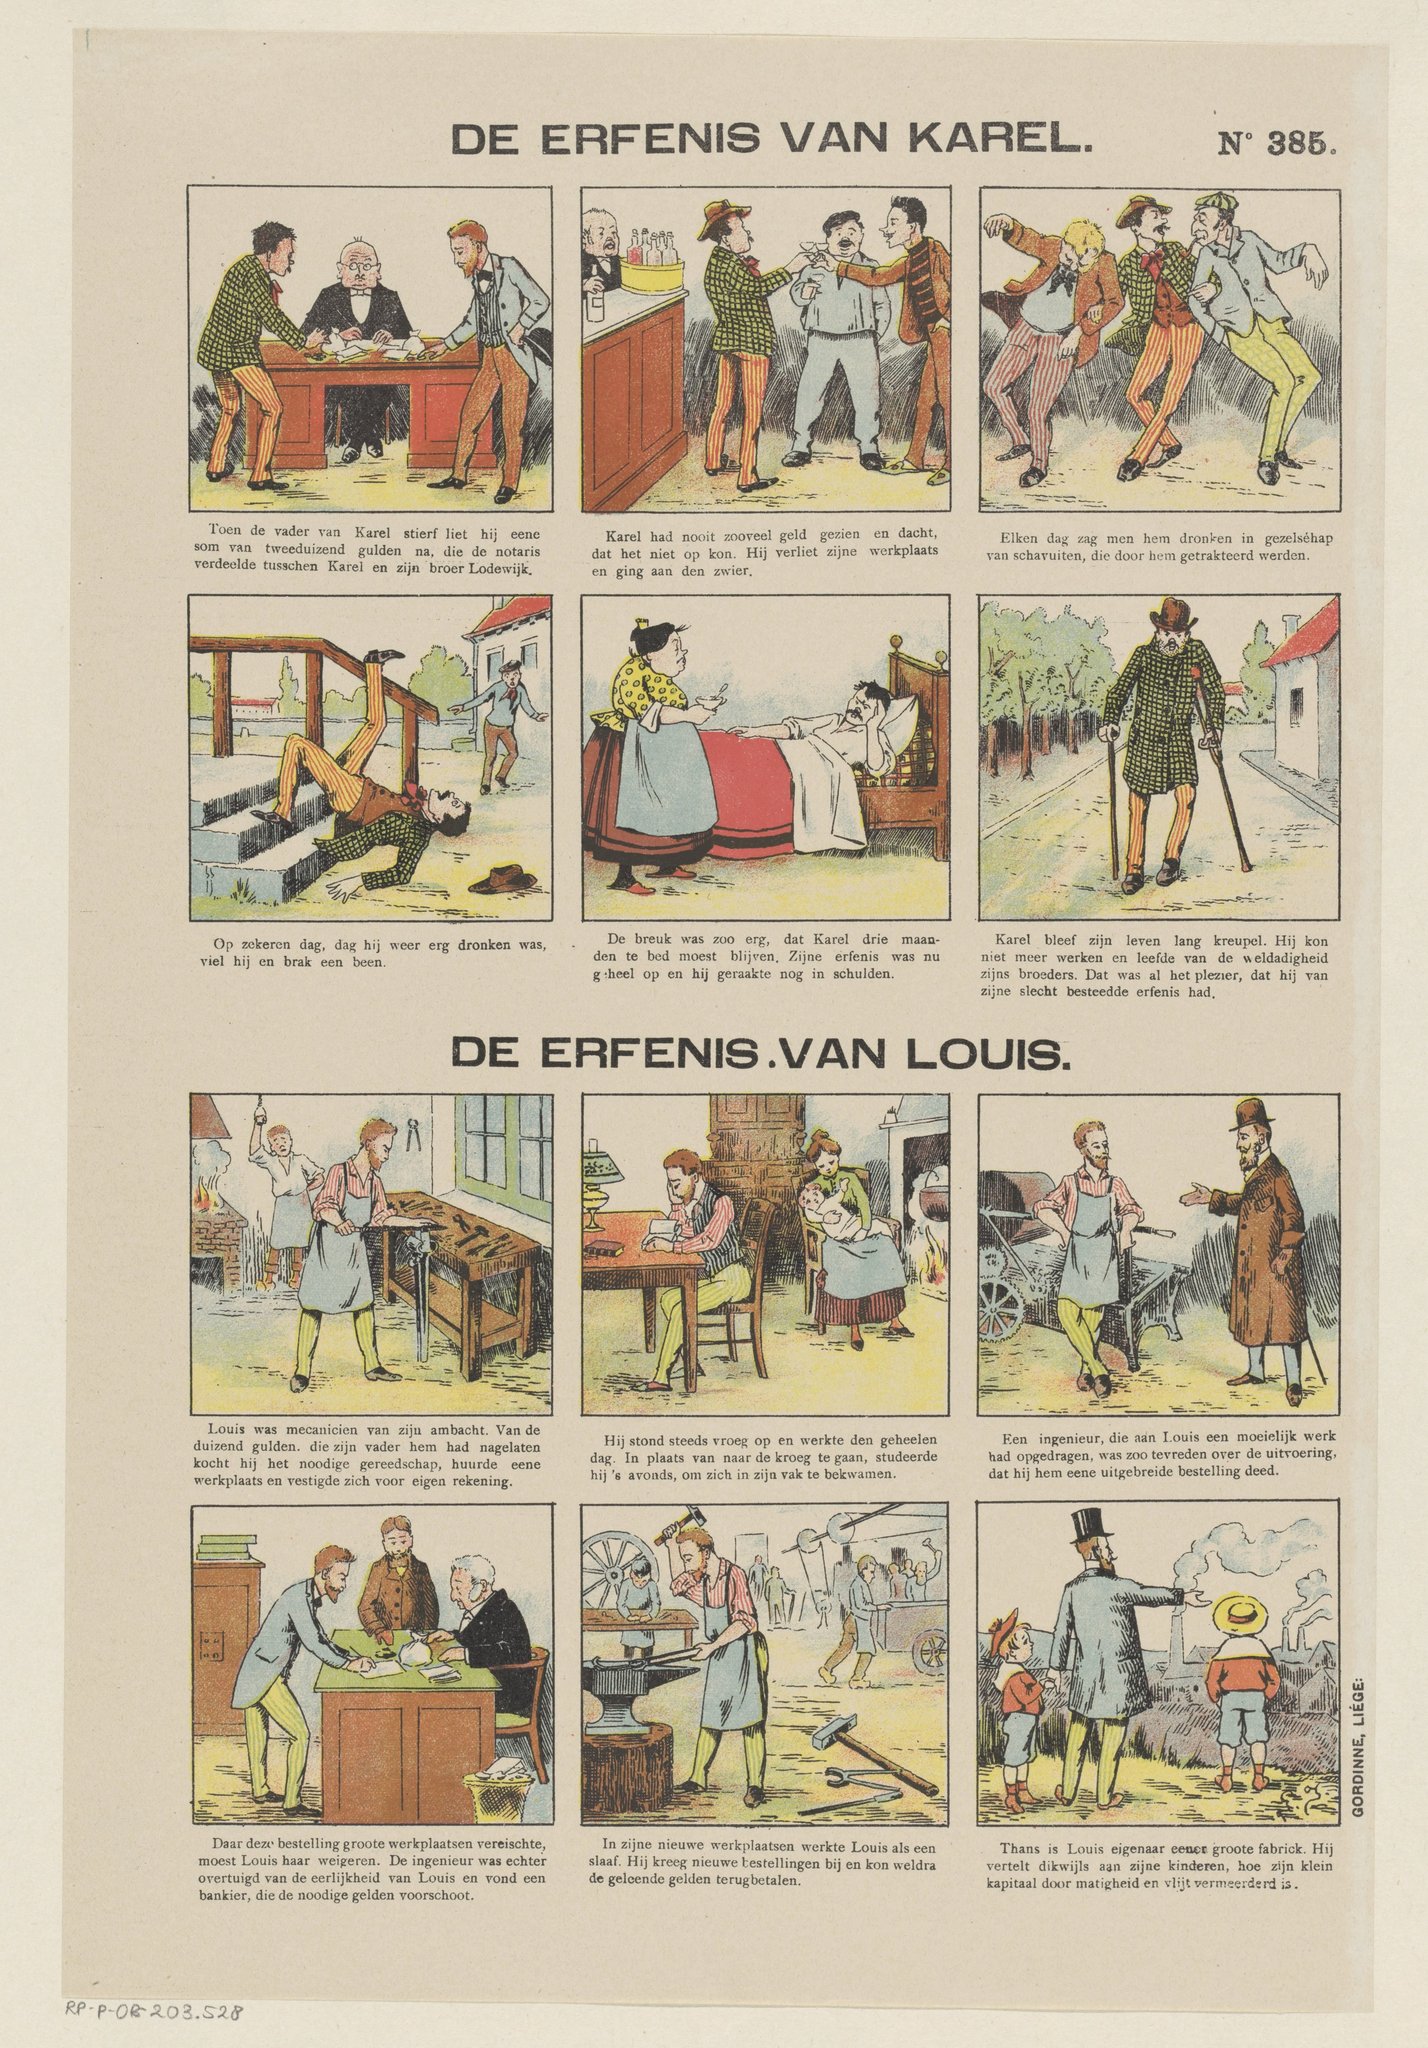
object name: popular print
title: De erfenis van Karel / De erfenis van Louis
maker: Anonymous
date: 1894-1959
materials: paper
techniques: lithograph, letterpress printing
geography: liège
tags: craft-production, skilled handiwork, sobriety; 'sobrietà', 'astinenza' (ripa), drunkard, bad behaviour, good behaviour, drunkenness, crafts and industries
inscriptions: collector's mark: Lugt 2760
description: Blad met 12 voorstellingen. Boven zes voorstellingen over Karel die de erfenis van zijn vader besteedt aan alcohol. Onder zes voorstellingen over Louis die de erfenis van zijn vader goed investeert en steeds hogerop klimt. Onder elke afbeelding een onderschrift. Genummerd rechtsboven: No 385.